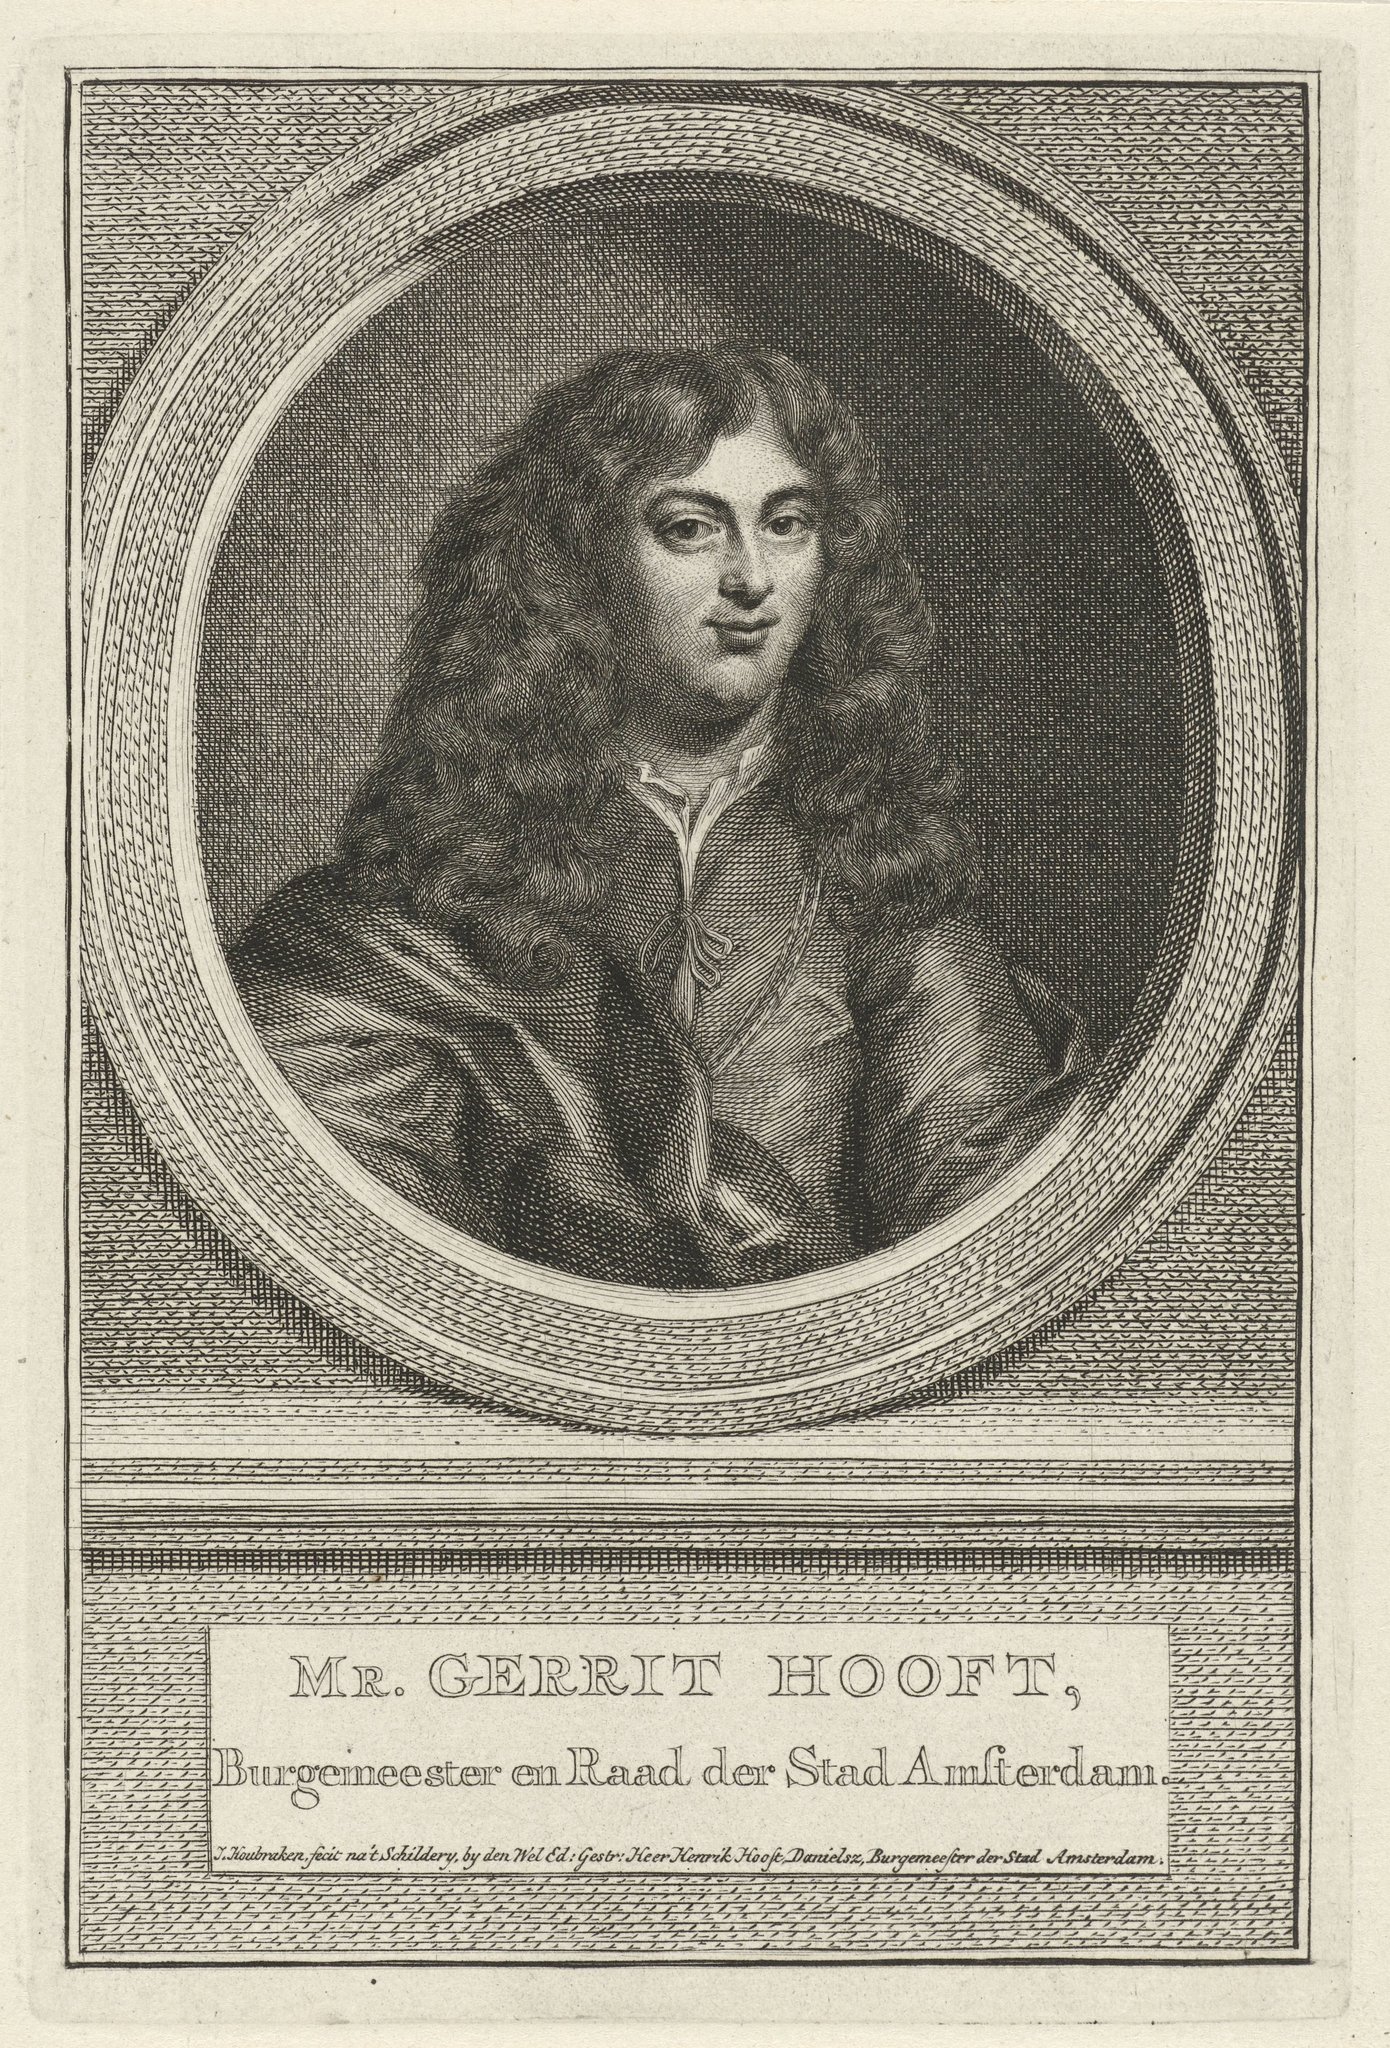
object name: print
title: Portret van Gerrit Hooft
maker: jacob houbraken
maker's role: draughtsman, print maker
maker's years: 1698-1780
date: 1696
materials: paper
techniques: engraving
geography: amsterdam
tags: mayor, historical persons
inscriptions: collector's mark: Lugt 2228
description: Deze prent is oorspronkelijk bedoeld als aanvulling op Jan Wagenaars ‘Vaderlandsche historie’* en was zo vanaf 1796 verkrijgbaar bij Johannes Allart te Amsterdam. Voor de advertentie waarin Allart de 60 portretten en 7 platen, allen gegraveerd door Houbraken, ter aanvulling op Wagenaars ‘Vaderlandsche historie’ aanbiedt, zie RP-P-OB-77.766. *Van dit werk zijn in de achttiende eeuw meerdere uitgaves verschenen, zoals: Wagenaar, Jan. Vaderlandsche historie, vervattende de geschiedenissen der Vereenigde Nederlanden (…). 21 delen. Amsterdam: Isaak Tirion, 1749-1759. Wagenaar, Jan. Vaderlandsche historie, vervattende de geschiedenissen der nu Vereenigde Nederlanden (…). 21 delen. Amsterdam: weduwe Isaak Tirion, 1770. Wagenaar, Jan. Vaderlandsche historie, vervattende de geschiedenissen der nu Vereenigde Nederlanden (…). 21 delen. Amsterdam, Leiden, Dordrecht en Harlingen: P. Schouten e.a., 1782. Wagenaar, Jan. Vaderlandsche historie, vervattende de geschiedenissen der nu Vereenigde Nederlanden (…). 21 delen. Amsterdam: Johannes Allart, 1790-1796.